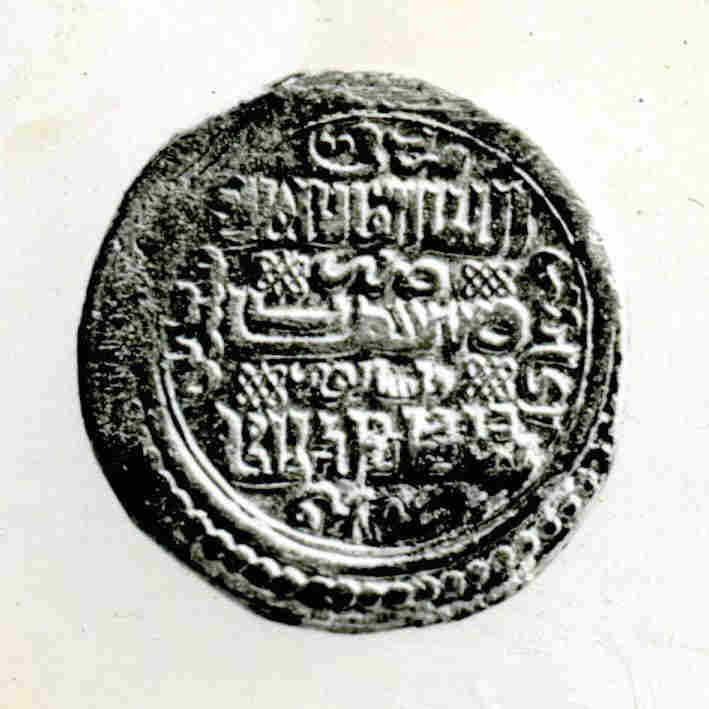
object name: coin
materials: copper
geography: iran